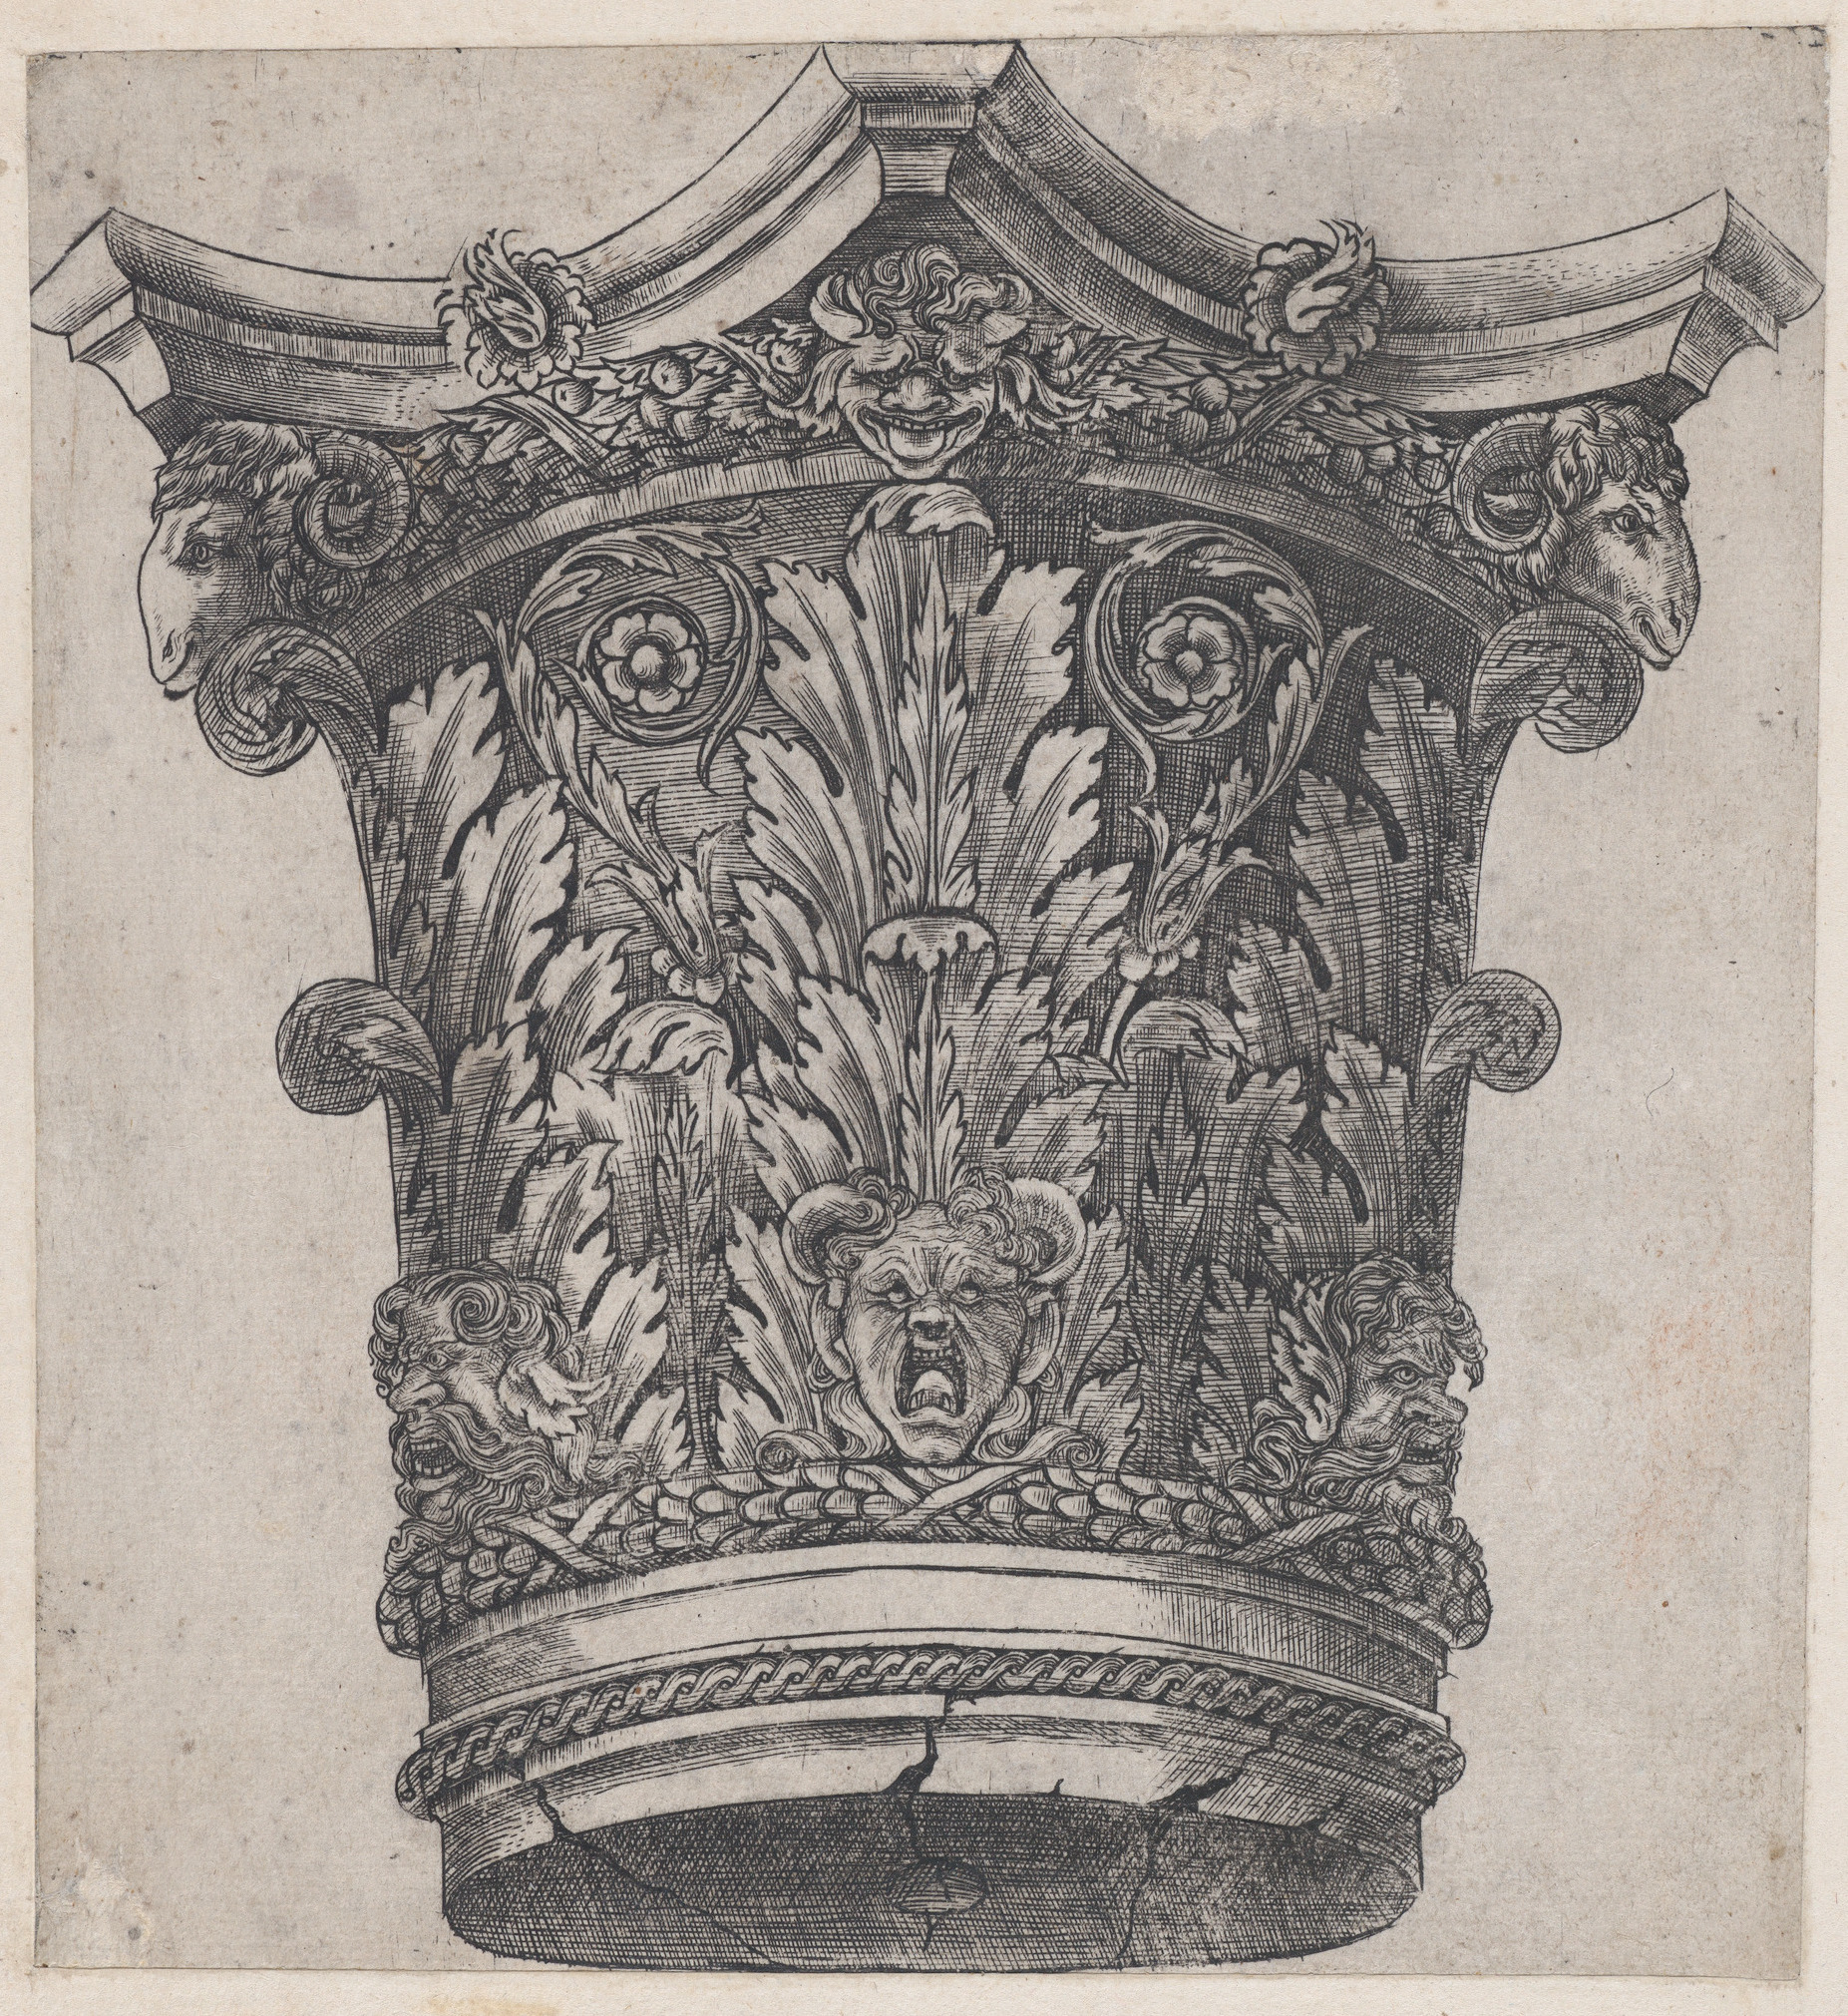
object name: print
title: Capital with ram heads and masks, from "Speculum Romanae Magnificentiae"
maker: monogrammist g.a. with the caltrop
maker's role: artist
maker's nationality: italian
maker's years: 1535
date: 1537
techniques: engraving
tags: capitals,rams